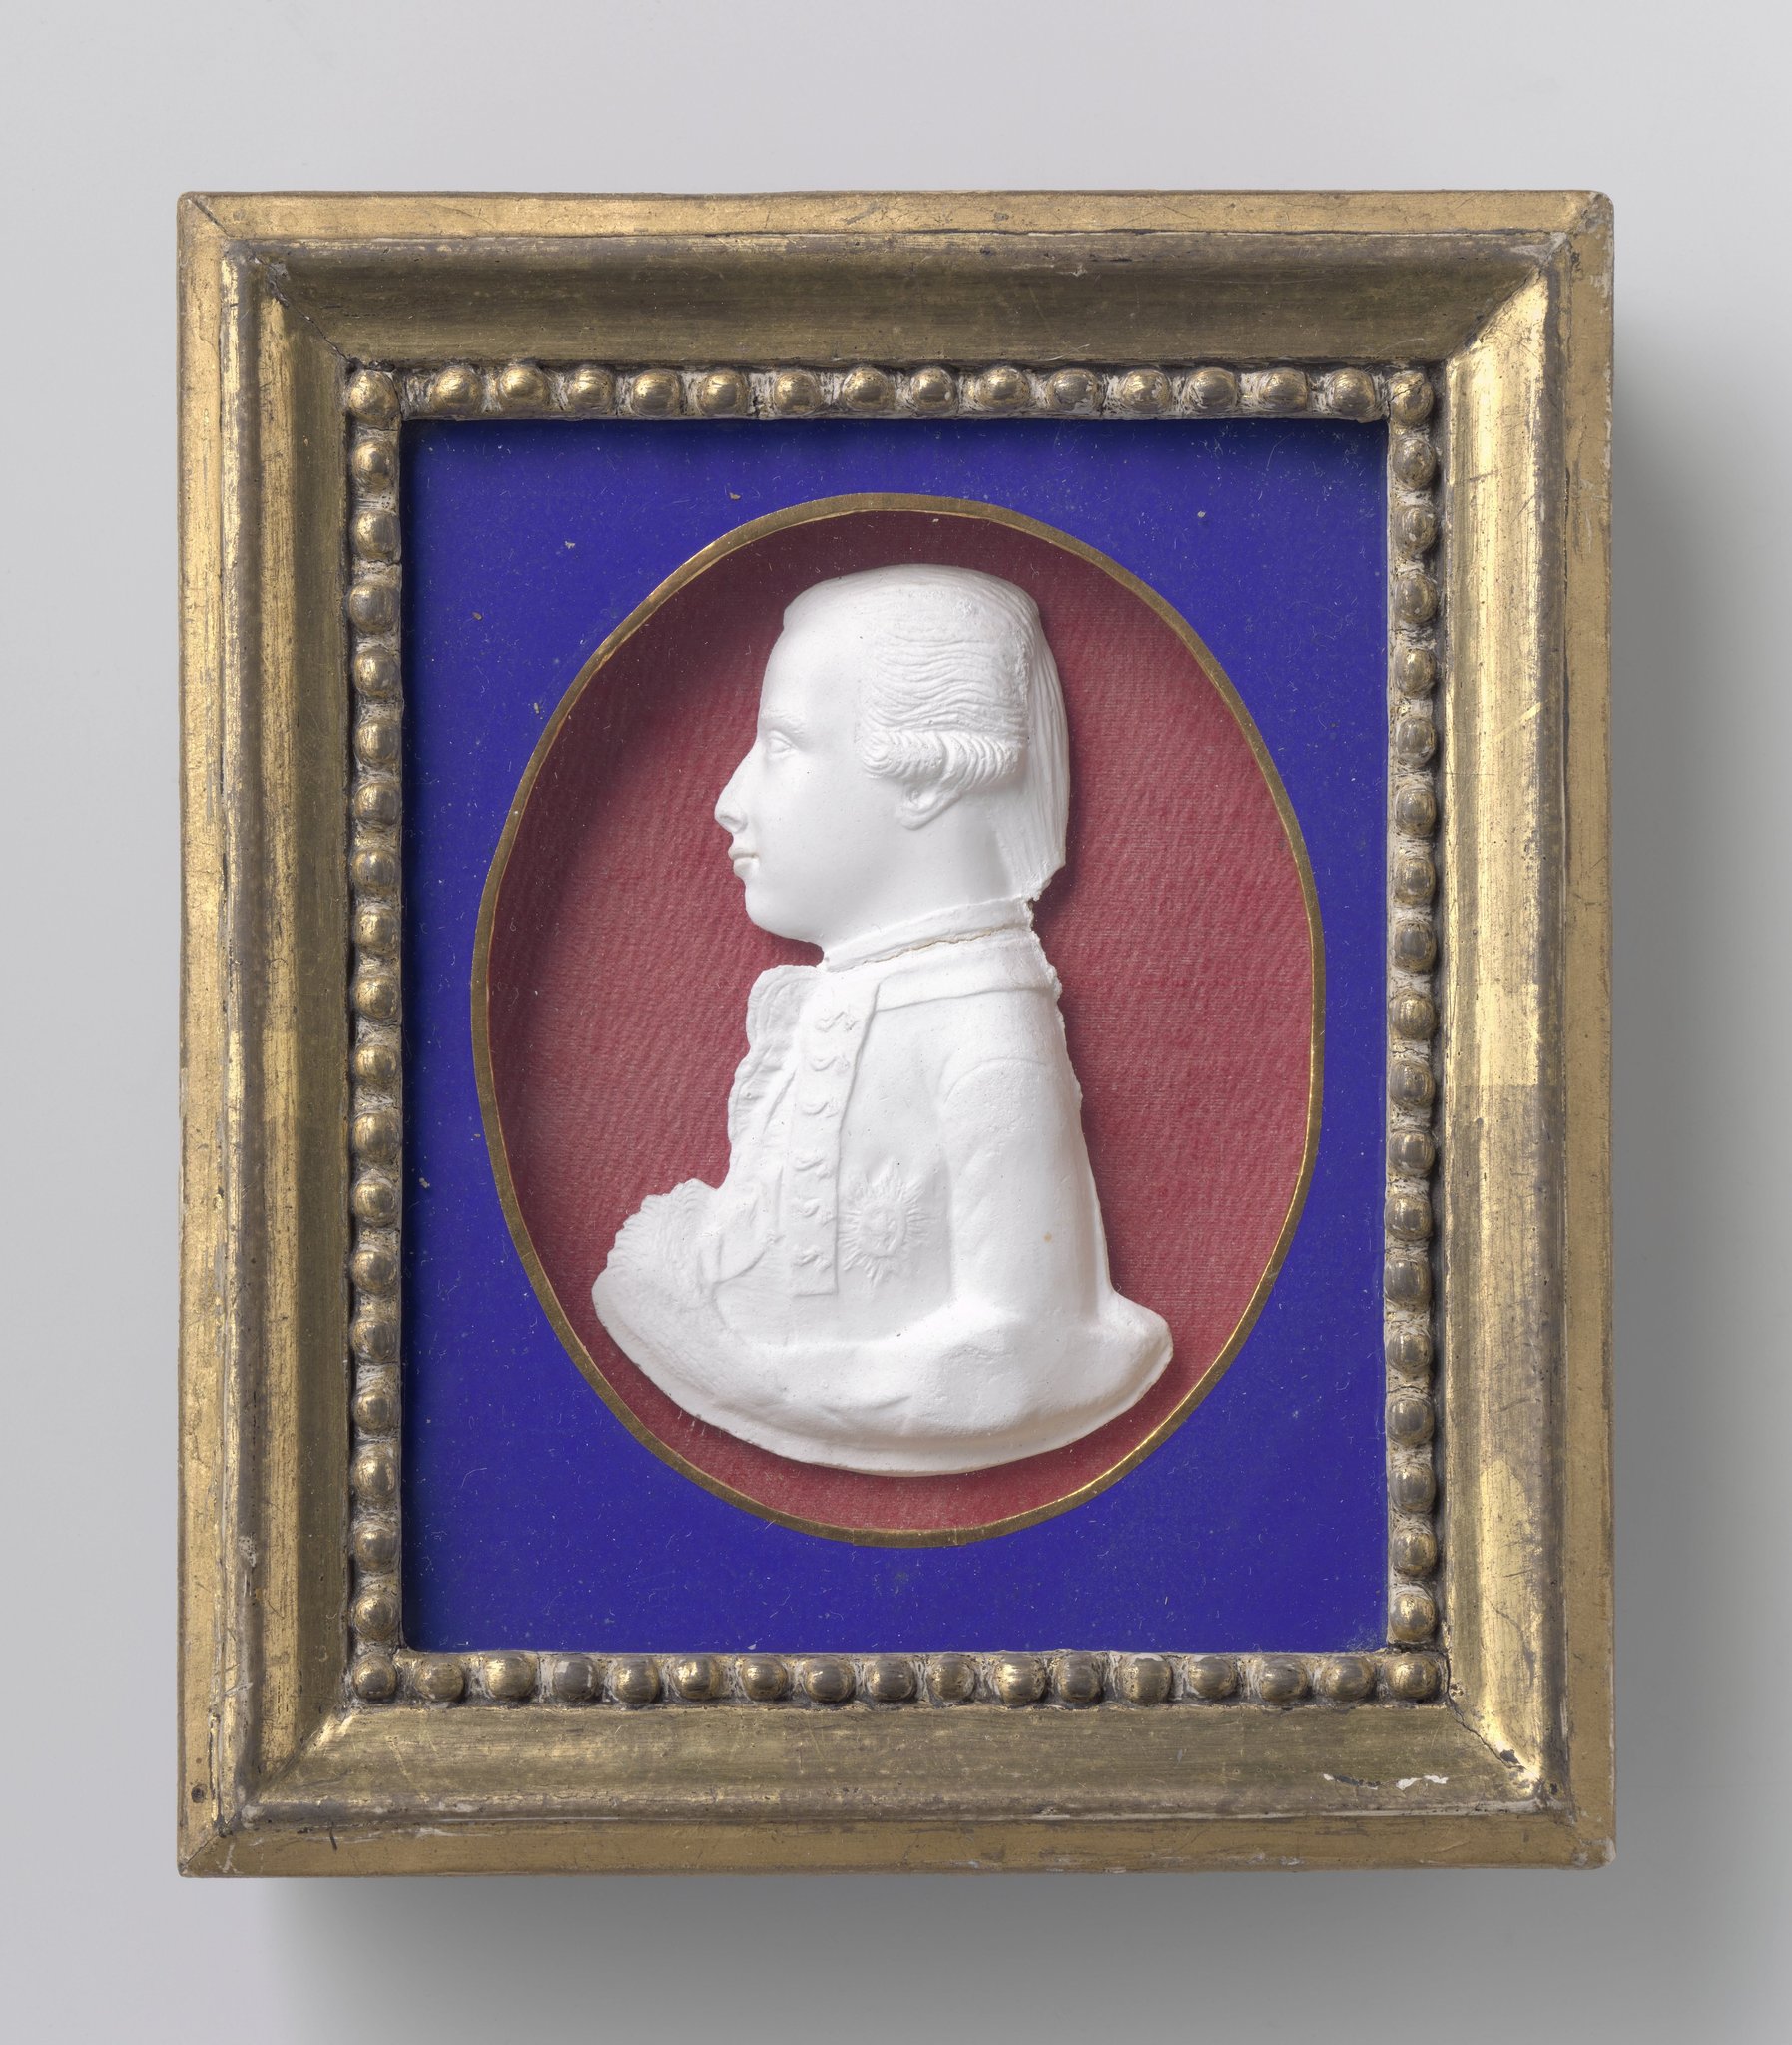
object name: portretmedaillon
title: Portretmedaillon van Prins Willem van Oranje, de latere Koning Willem I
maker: johann heinrich schepp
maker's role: sculptor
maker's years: 1736-1811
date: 1784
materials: gypsum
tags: the hague, berlin, william i of the netherlands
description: Portretmedaillon van Prins Willem van Oranje, de latere Koning Willem I. De prins, naar links, draagt een staartpruik, de uniformjas van de gardes du corps, een jabot, ordelint en ordeteken. Om zijn middel is een mantel gedrapeerd.